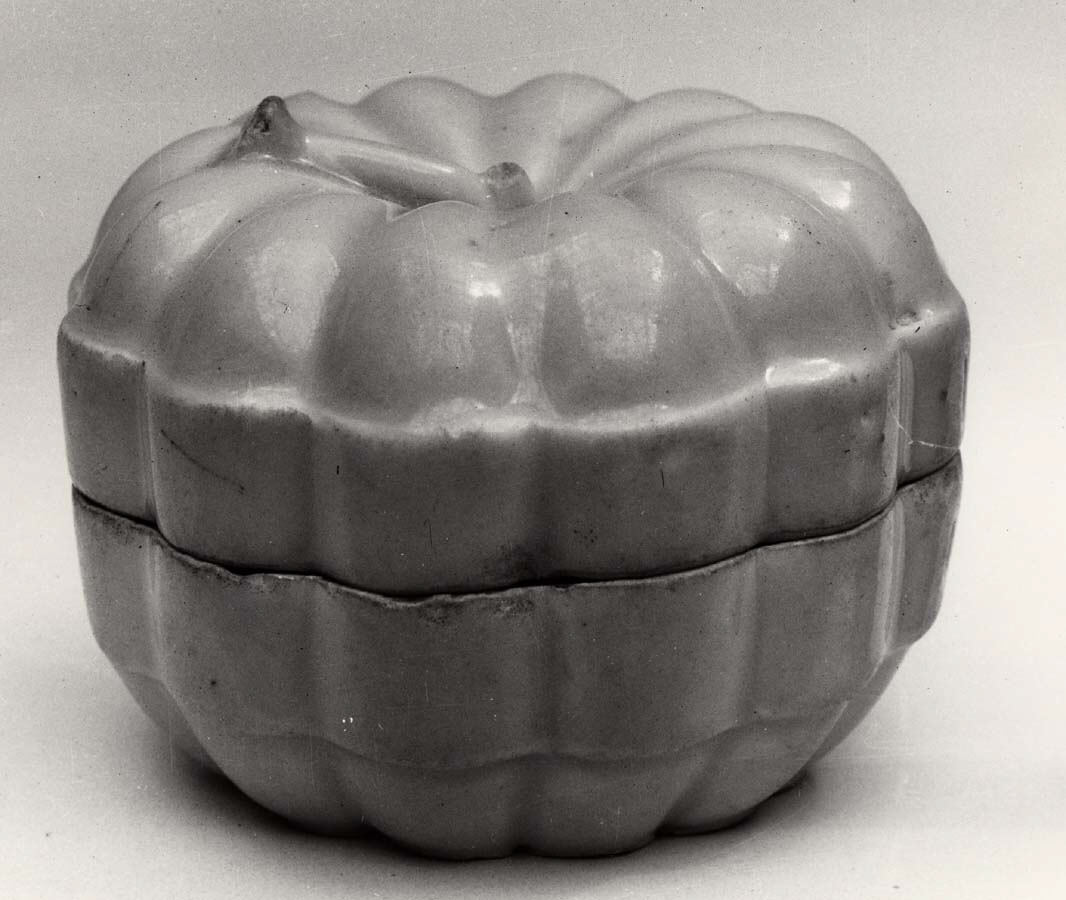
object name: box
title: Box in the shape of a melon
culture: chinese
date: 1001-1200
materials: glaze, porcelain